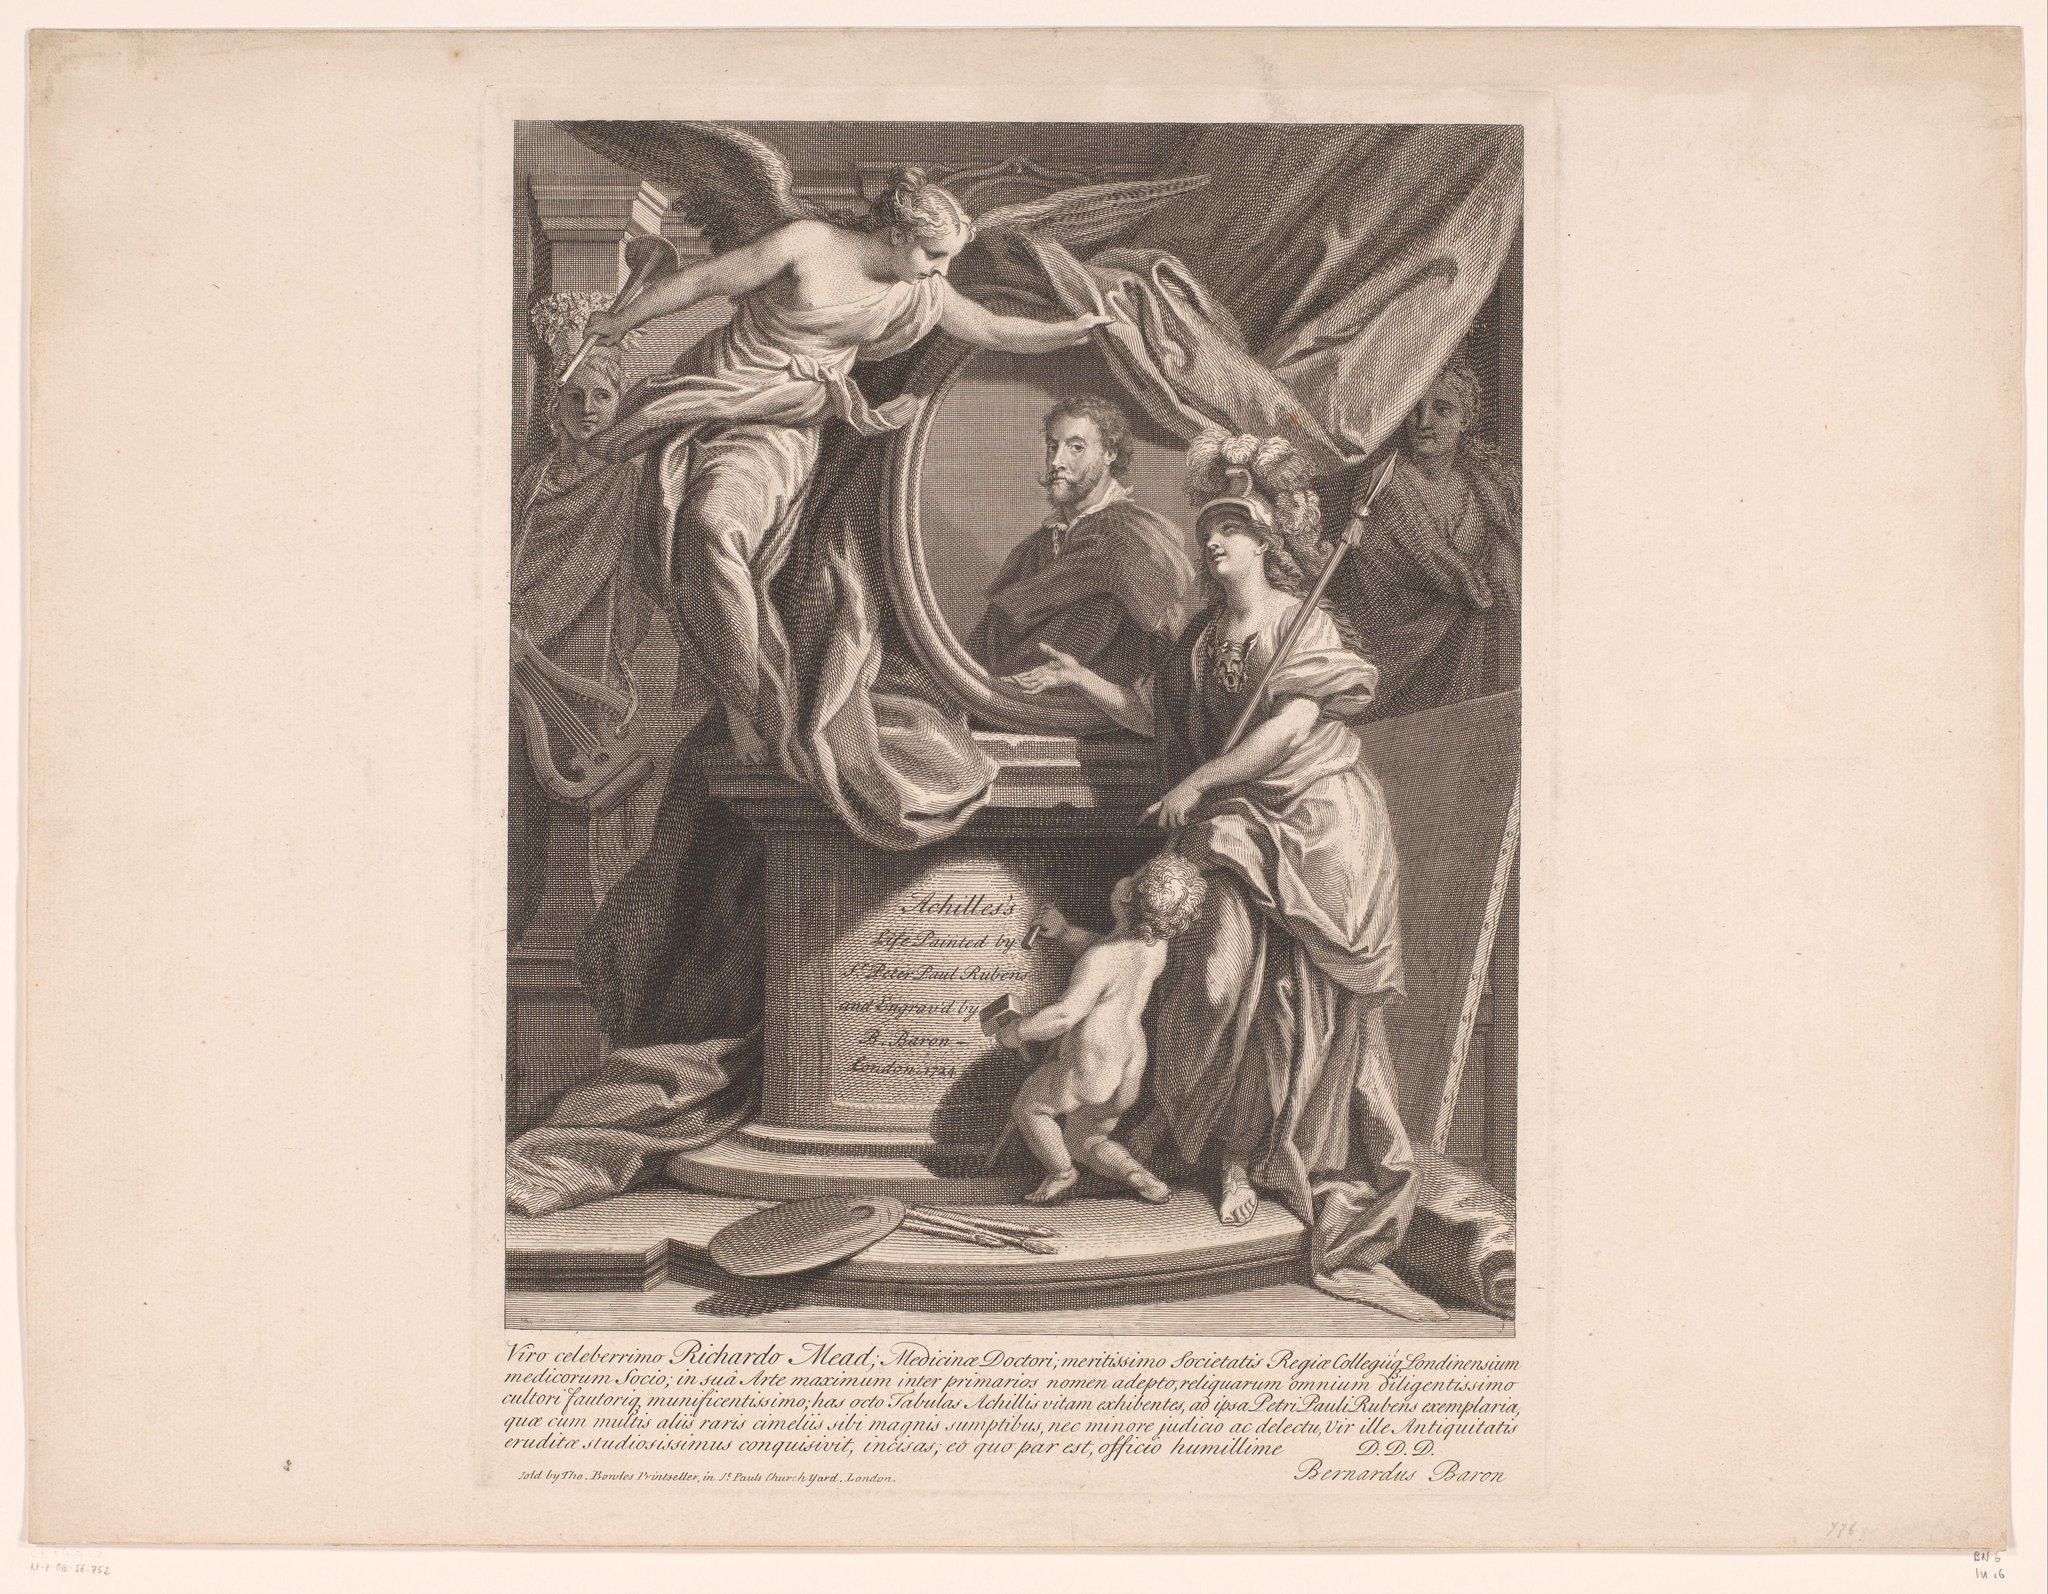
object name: titelprent, frontispice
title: Vie d'Achille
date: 1724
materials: paper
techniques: engraving, etching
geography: london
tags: antwerp, painter, print maker, draughtsman, peter paul rubens, historical persons, picture within picture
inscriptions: collector's mark: Lugt 240